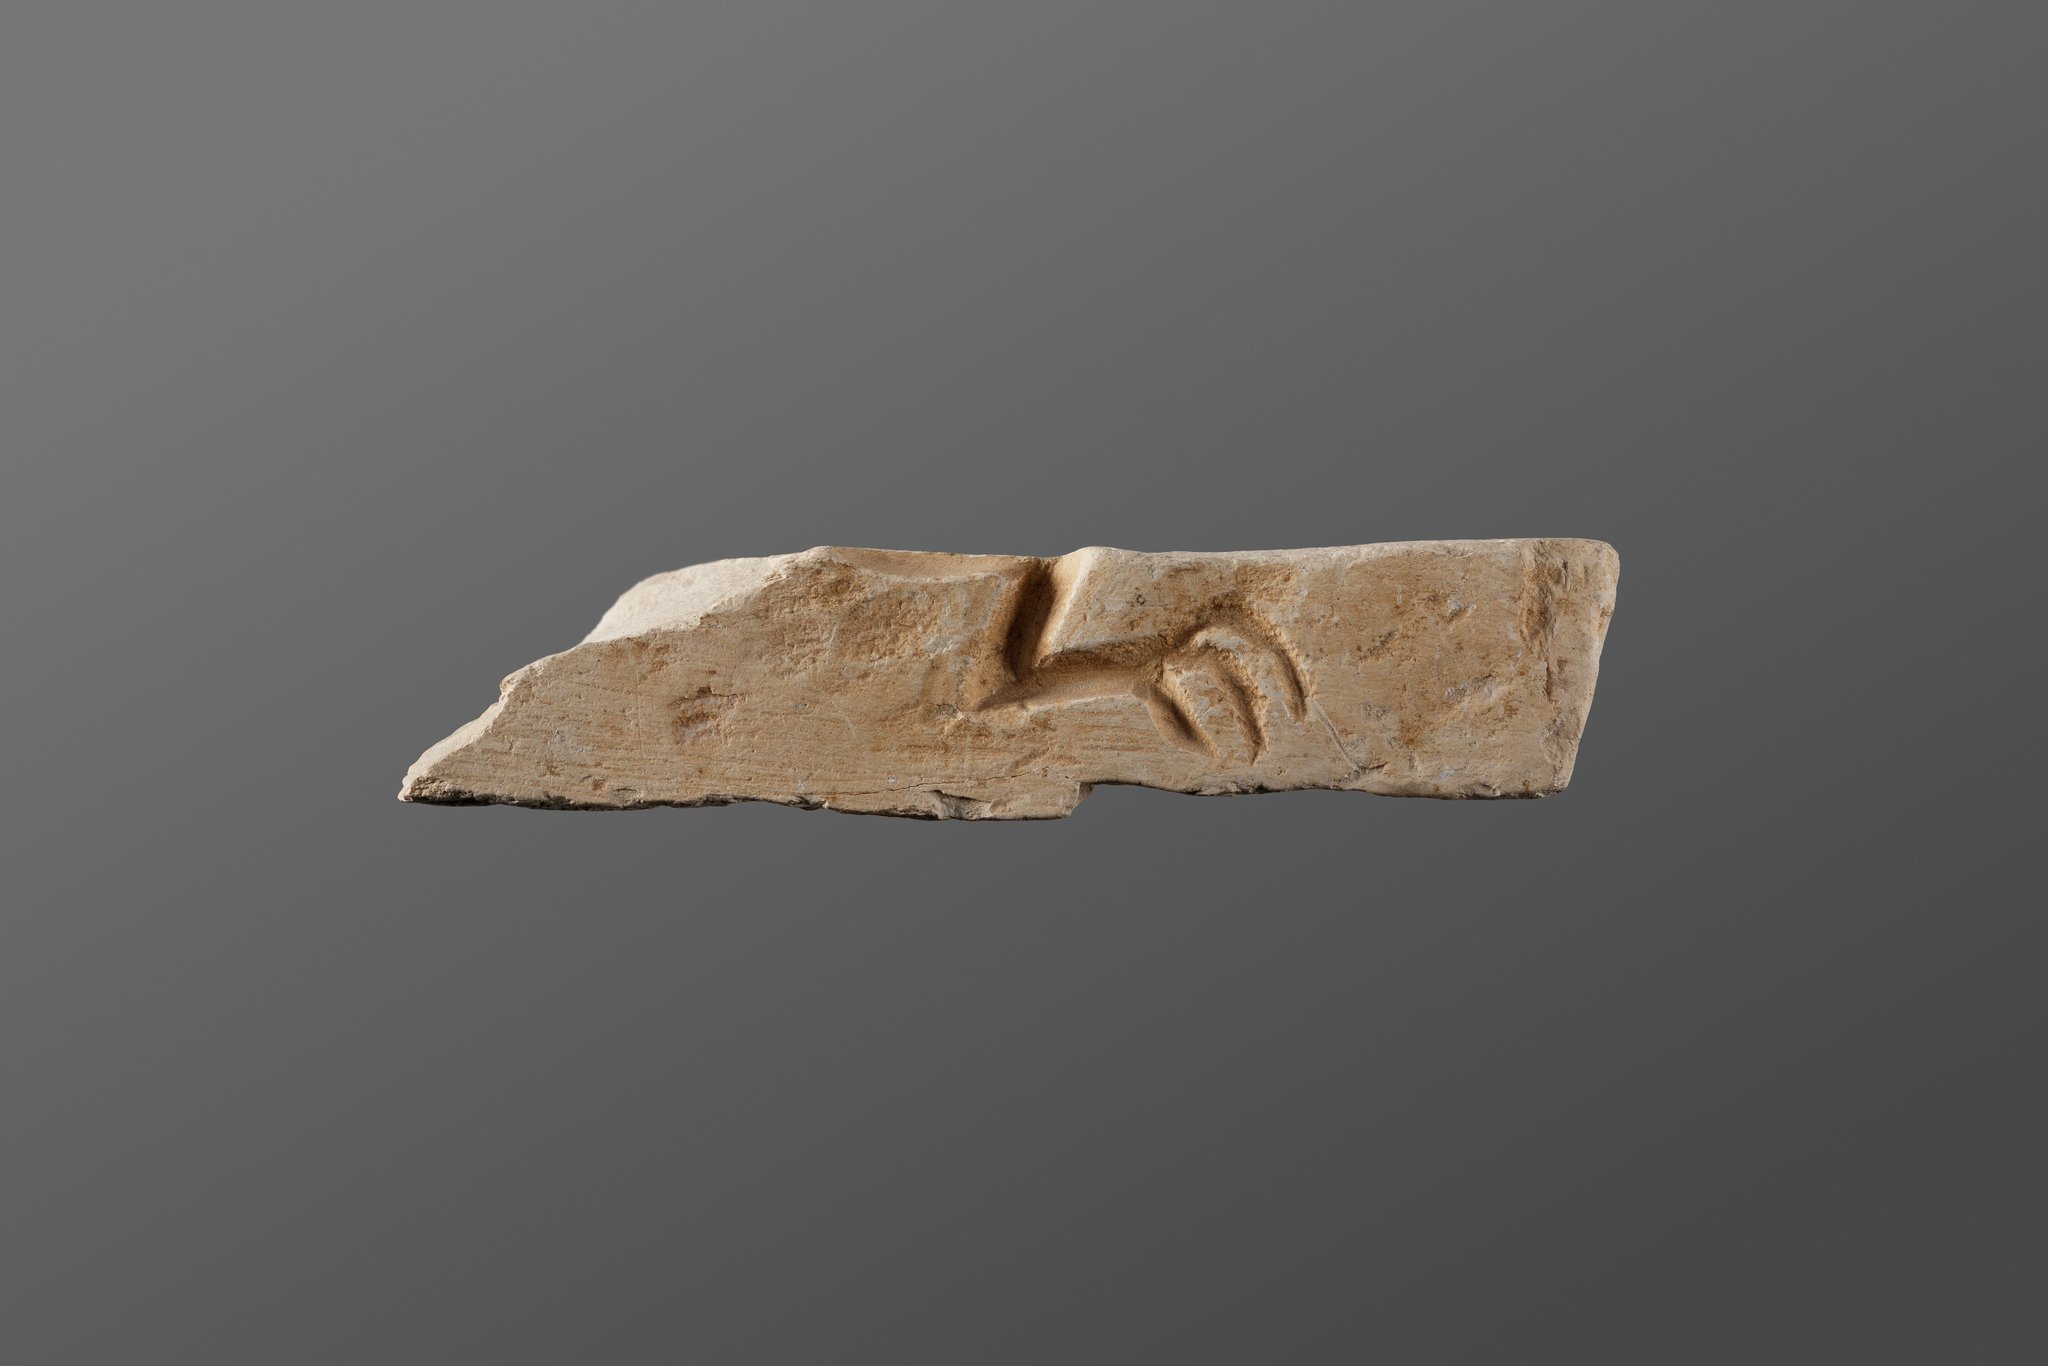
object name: relief fragment 47, tomb of mereri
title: Relief fragment possibly from the tomb of Mereri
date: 2100-2090 BCE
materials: stone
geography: egypt